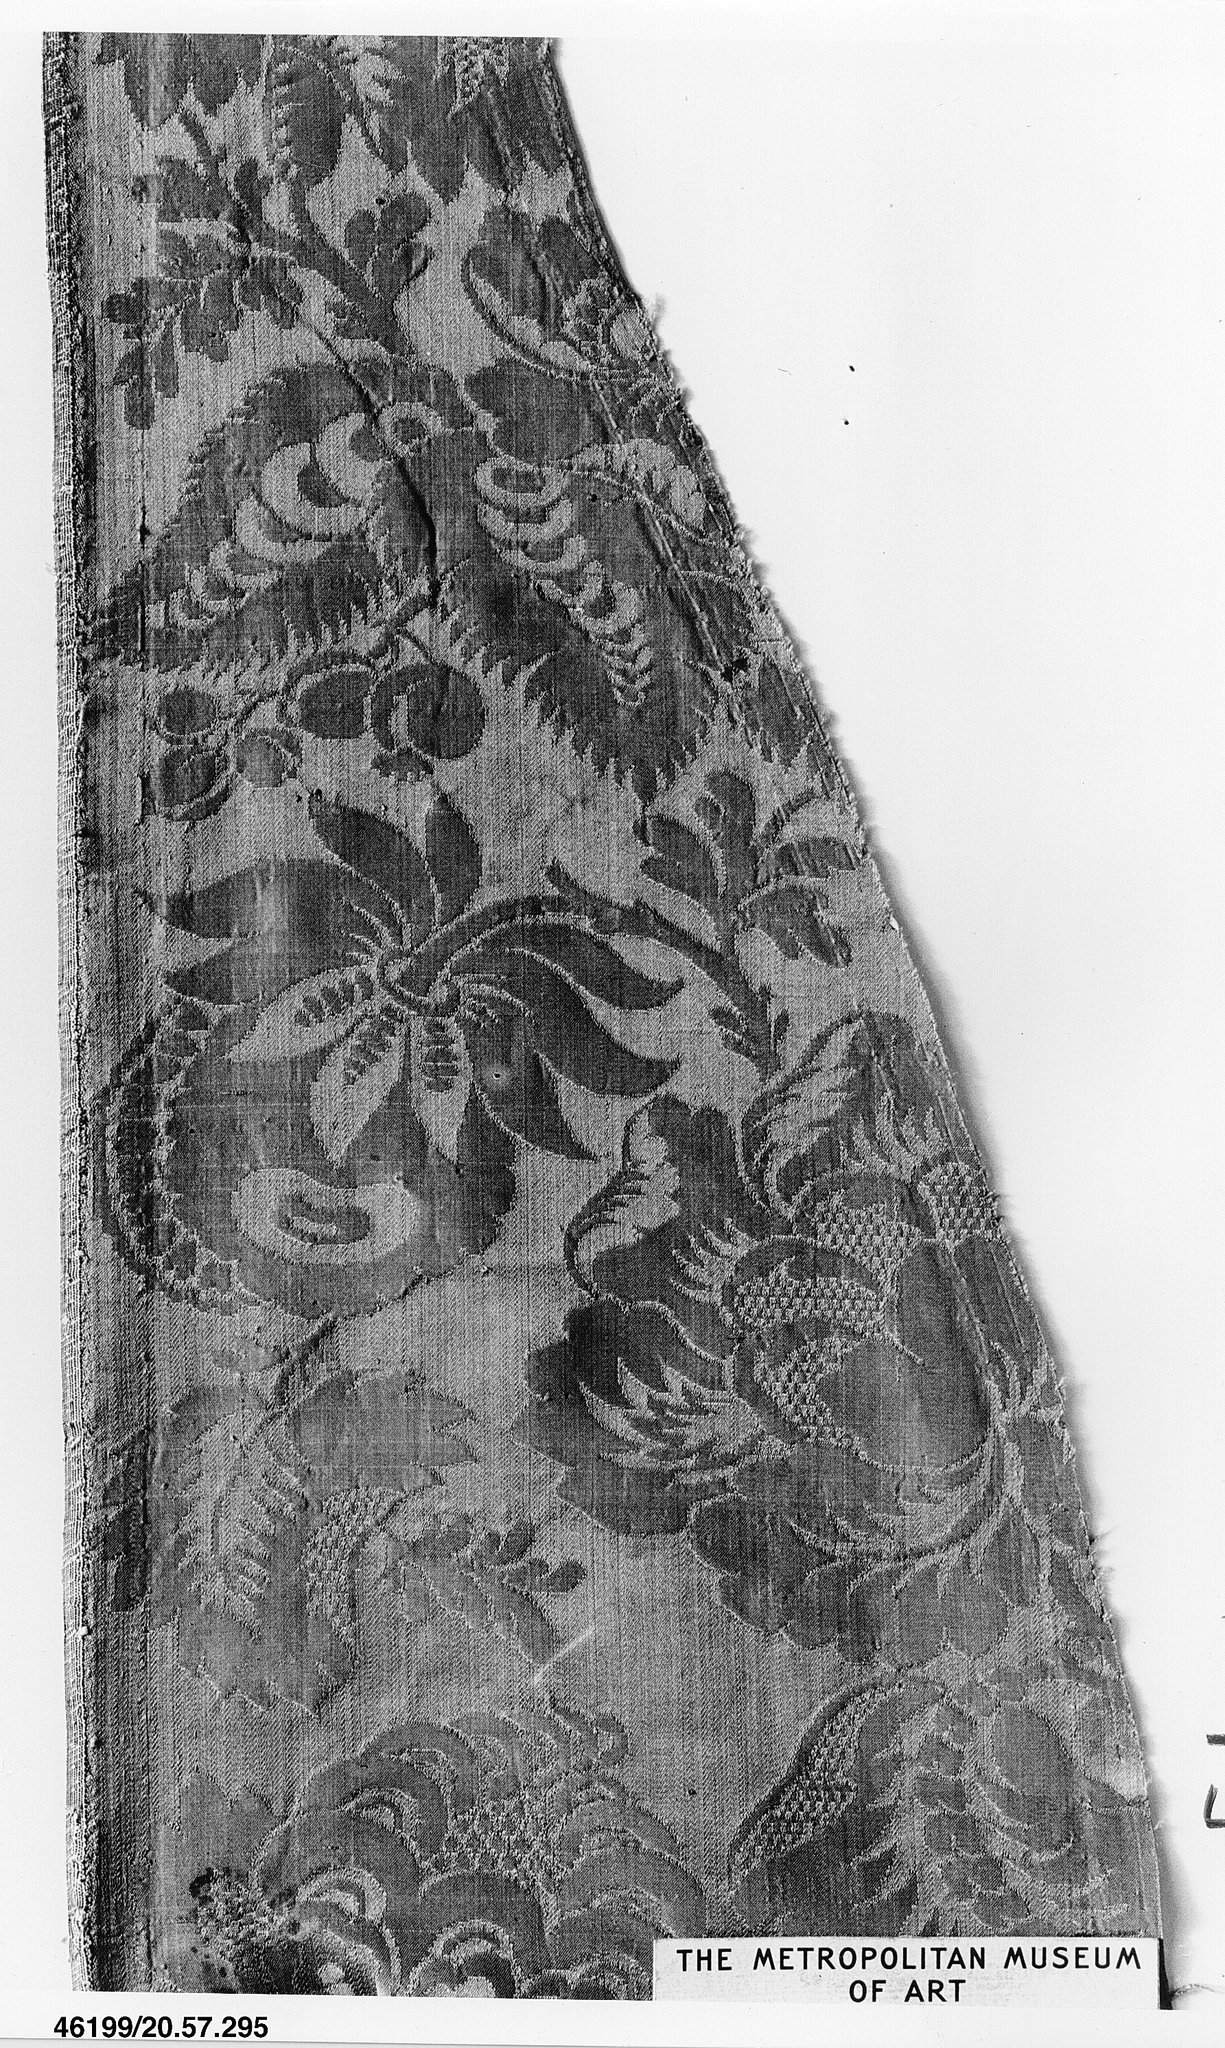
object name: piece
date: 1730-1740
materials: silk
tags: flowers,leaves